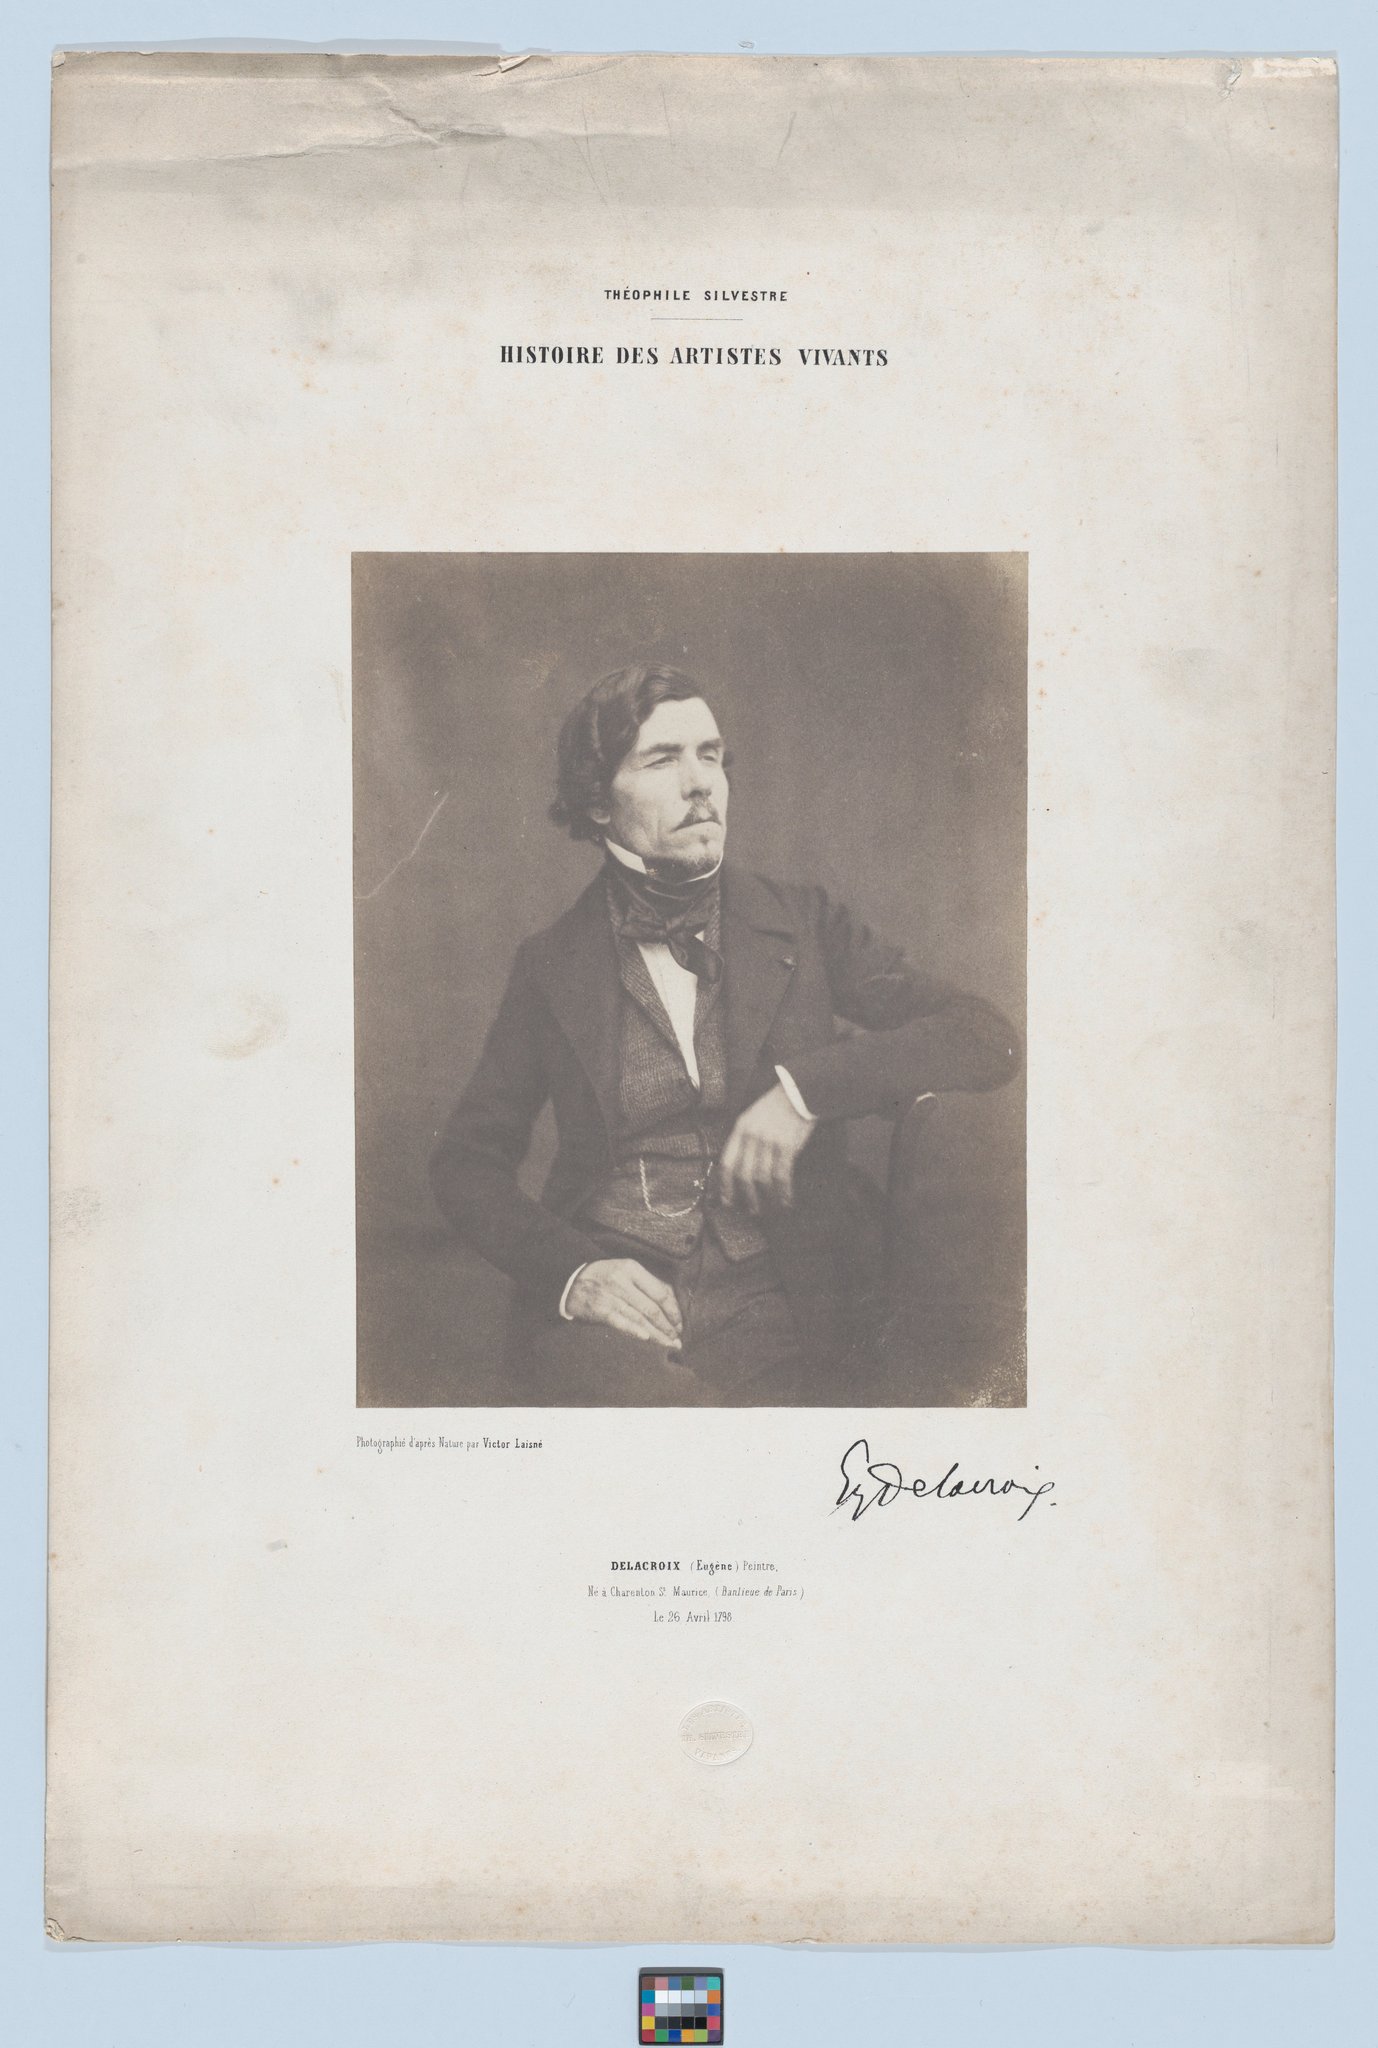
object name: photograph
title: Portrait of Delacroix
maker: victor laisné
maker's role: artist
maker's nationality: french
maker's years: 1807-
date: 1853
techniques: salted paper print